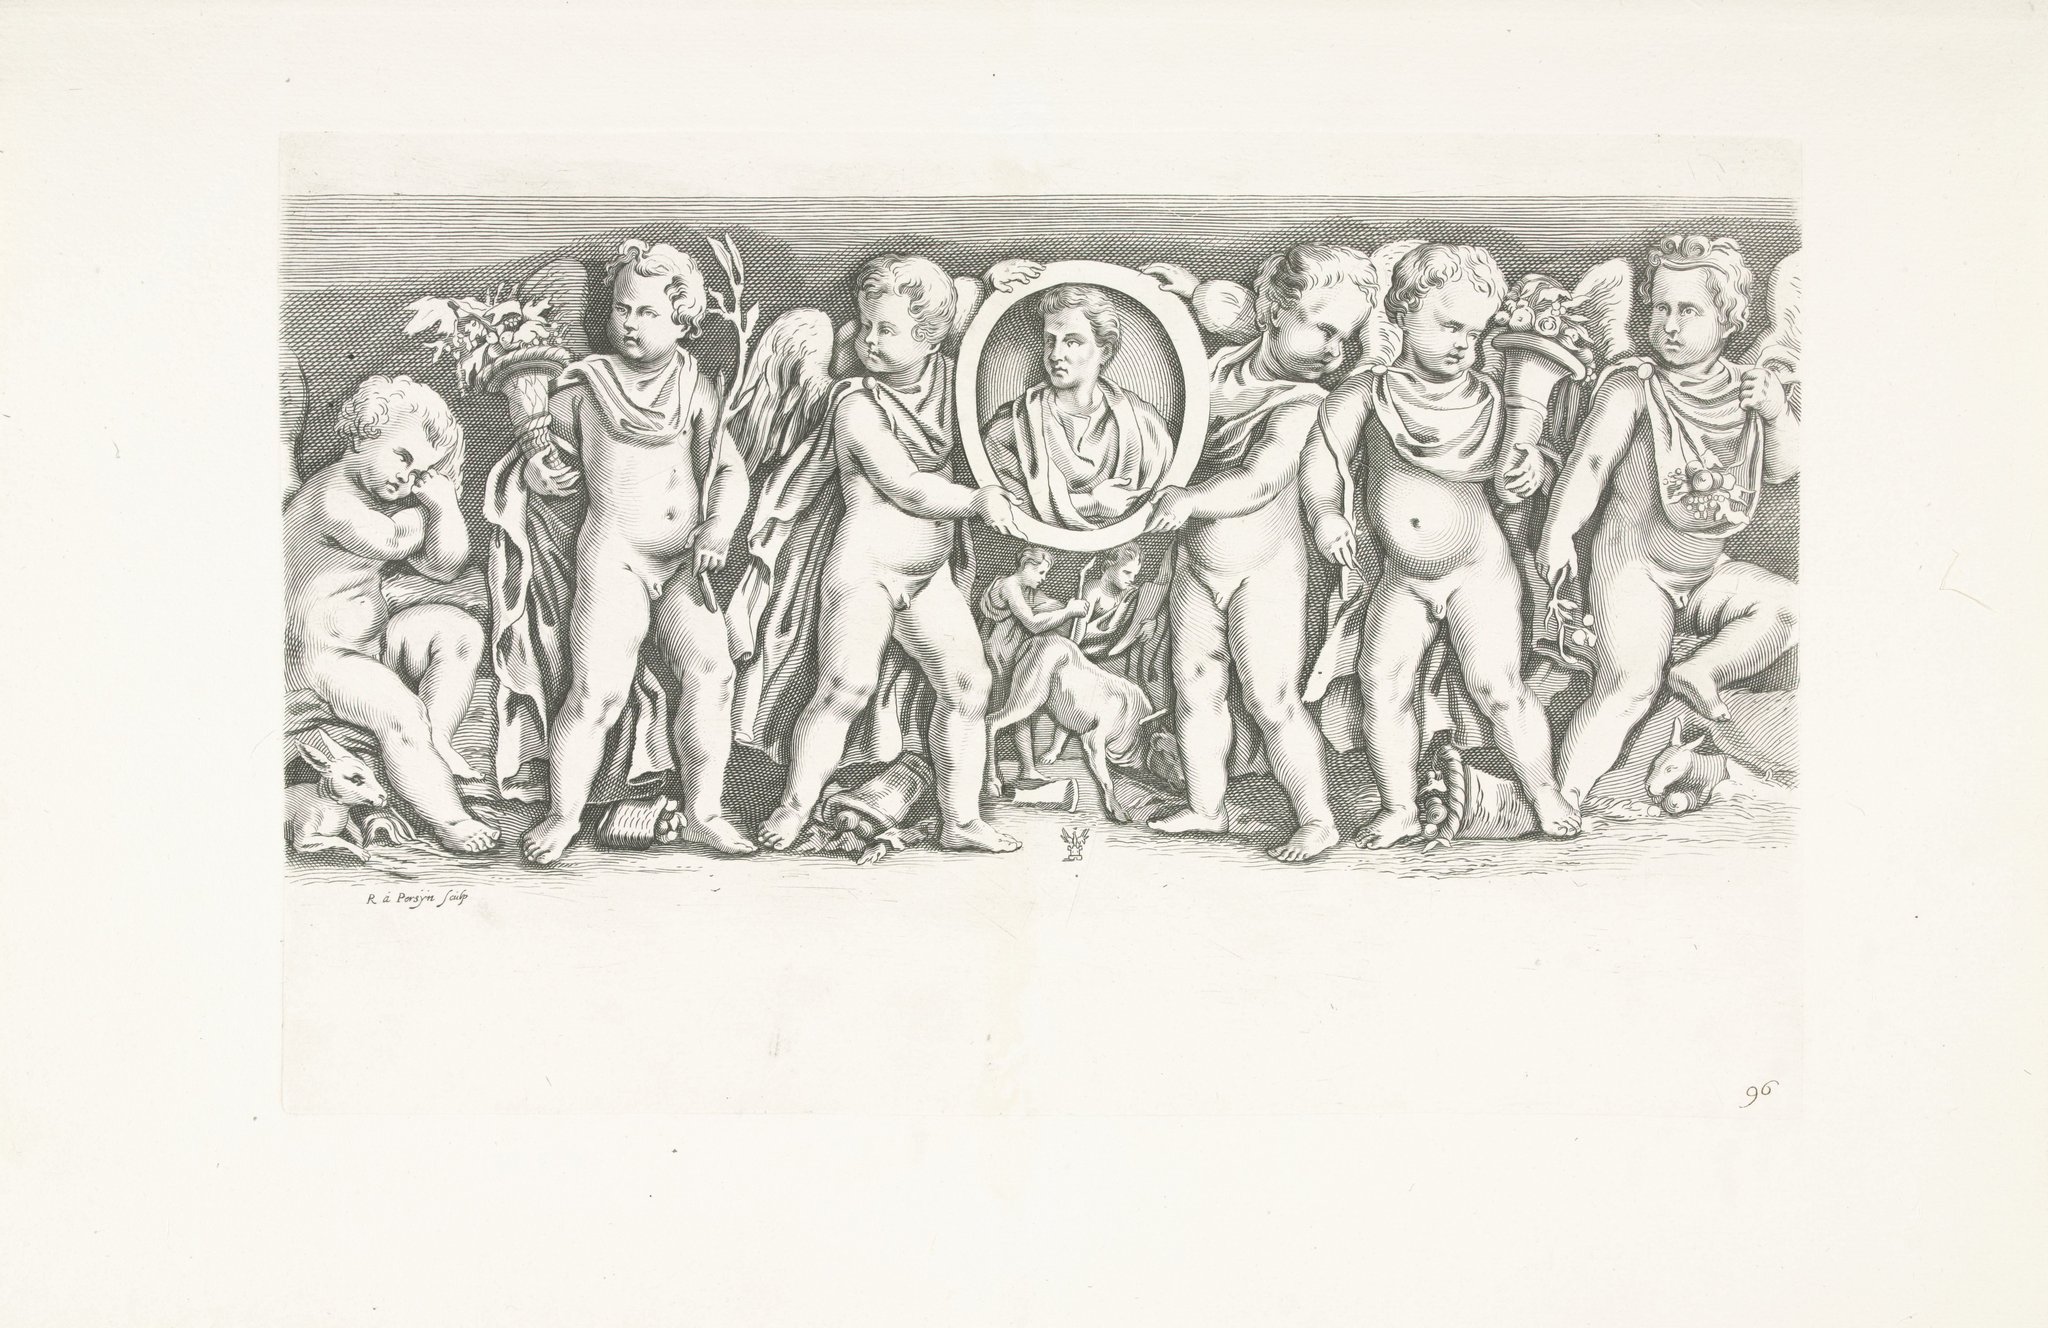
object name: print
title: Galleria Giustiniana del Marchese Vincenzo Giustiniani II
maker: reinier van persijn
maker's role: draughtsman, painter, print maker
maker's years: 1614-1668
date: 1640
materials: paper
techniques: engraving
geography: rome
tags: rome, vincenzo giustiniani (1564-1637), piece of sculpture, reproduction of a piece of sculpture, cupids: 'amores', 'amoretti', 'putti'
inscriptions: collector's mark: Lugt 2228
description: Romeins bas-reliëf van een groep putti, van wie er twee een portret vasthouden. (Waarschijnlijk een fragment van een sacrcofaag.) Midden onder het wapenschild van Vincenzo Giustiniani. Prent uit een publicatie met reproductieprenten naar de sculpturen in de verzameling in de Galleria Giustiniani te Rome.